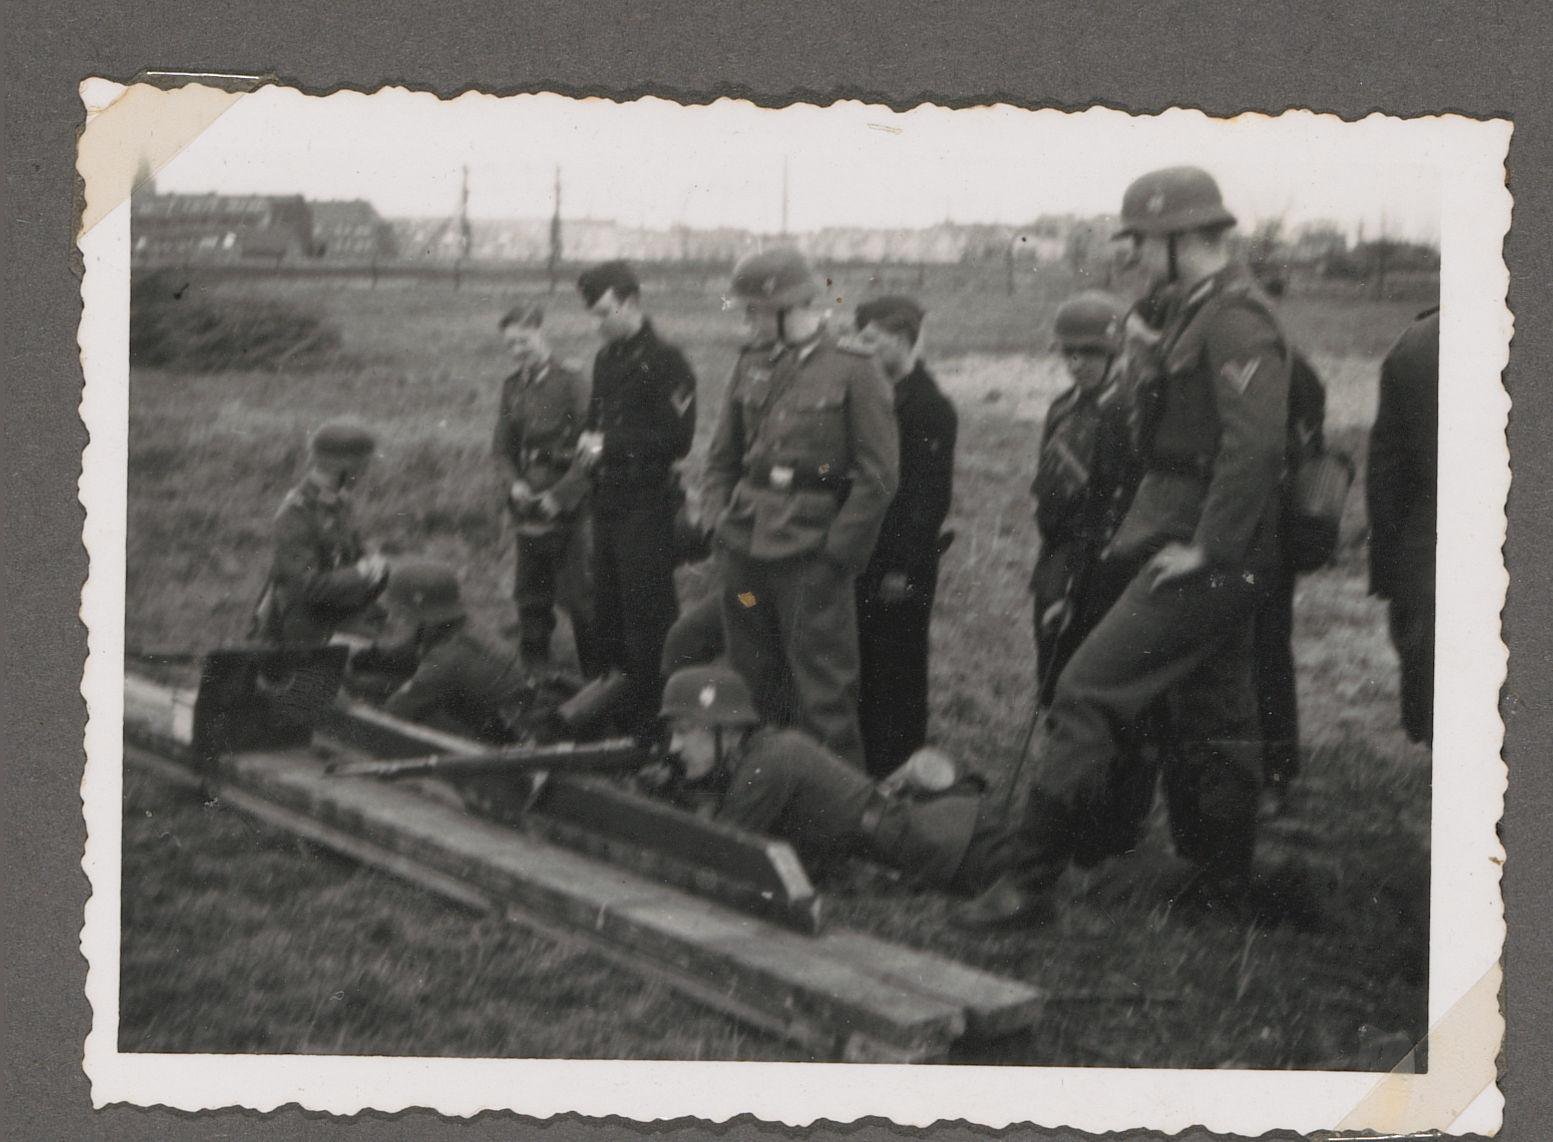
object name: photograph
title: Militairen tijdens een schietoefening te Vlaardingen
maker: Anonymous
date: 1935-1945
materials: paper, photographic support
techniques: gelatin silver print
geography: vlaardingen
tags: military training (+ cavalry, horsemen), historical persons, the soldier; the soldier's life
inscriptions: annotation: ‘Beim Schießendes U-stabes in Vlaardingen’